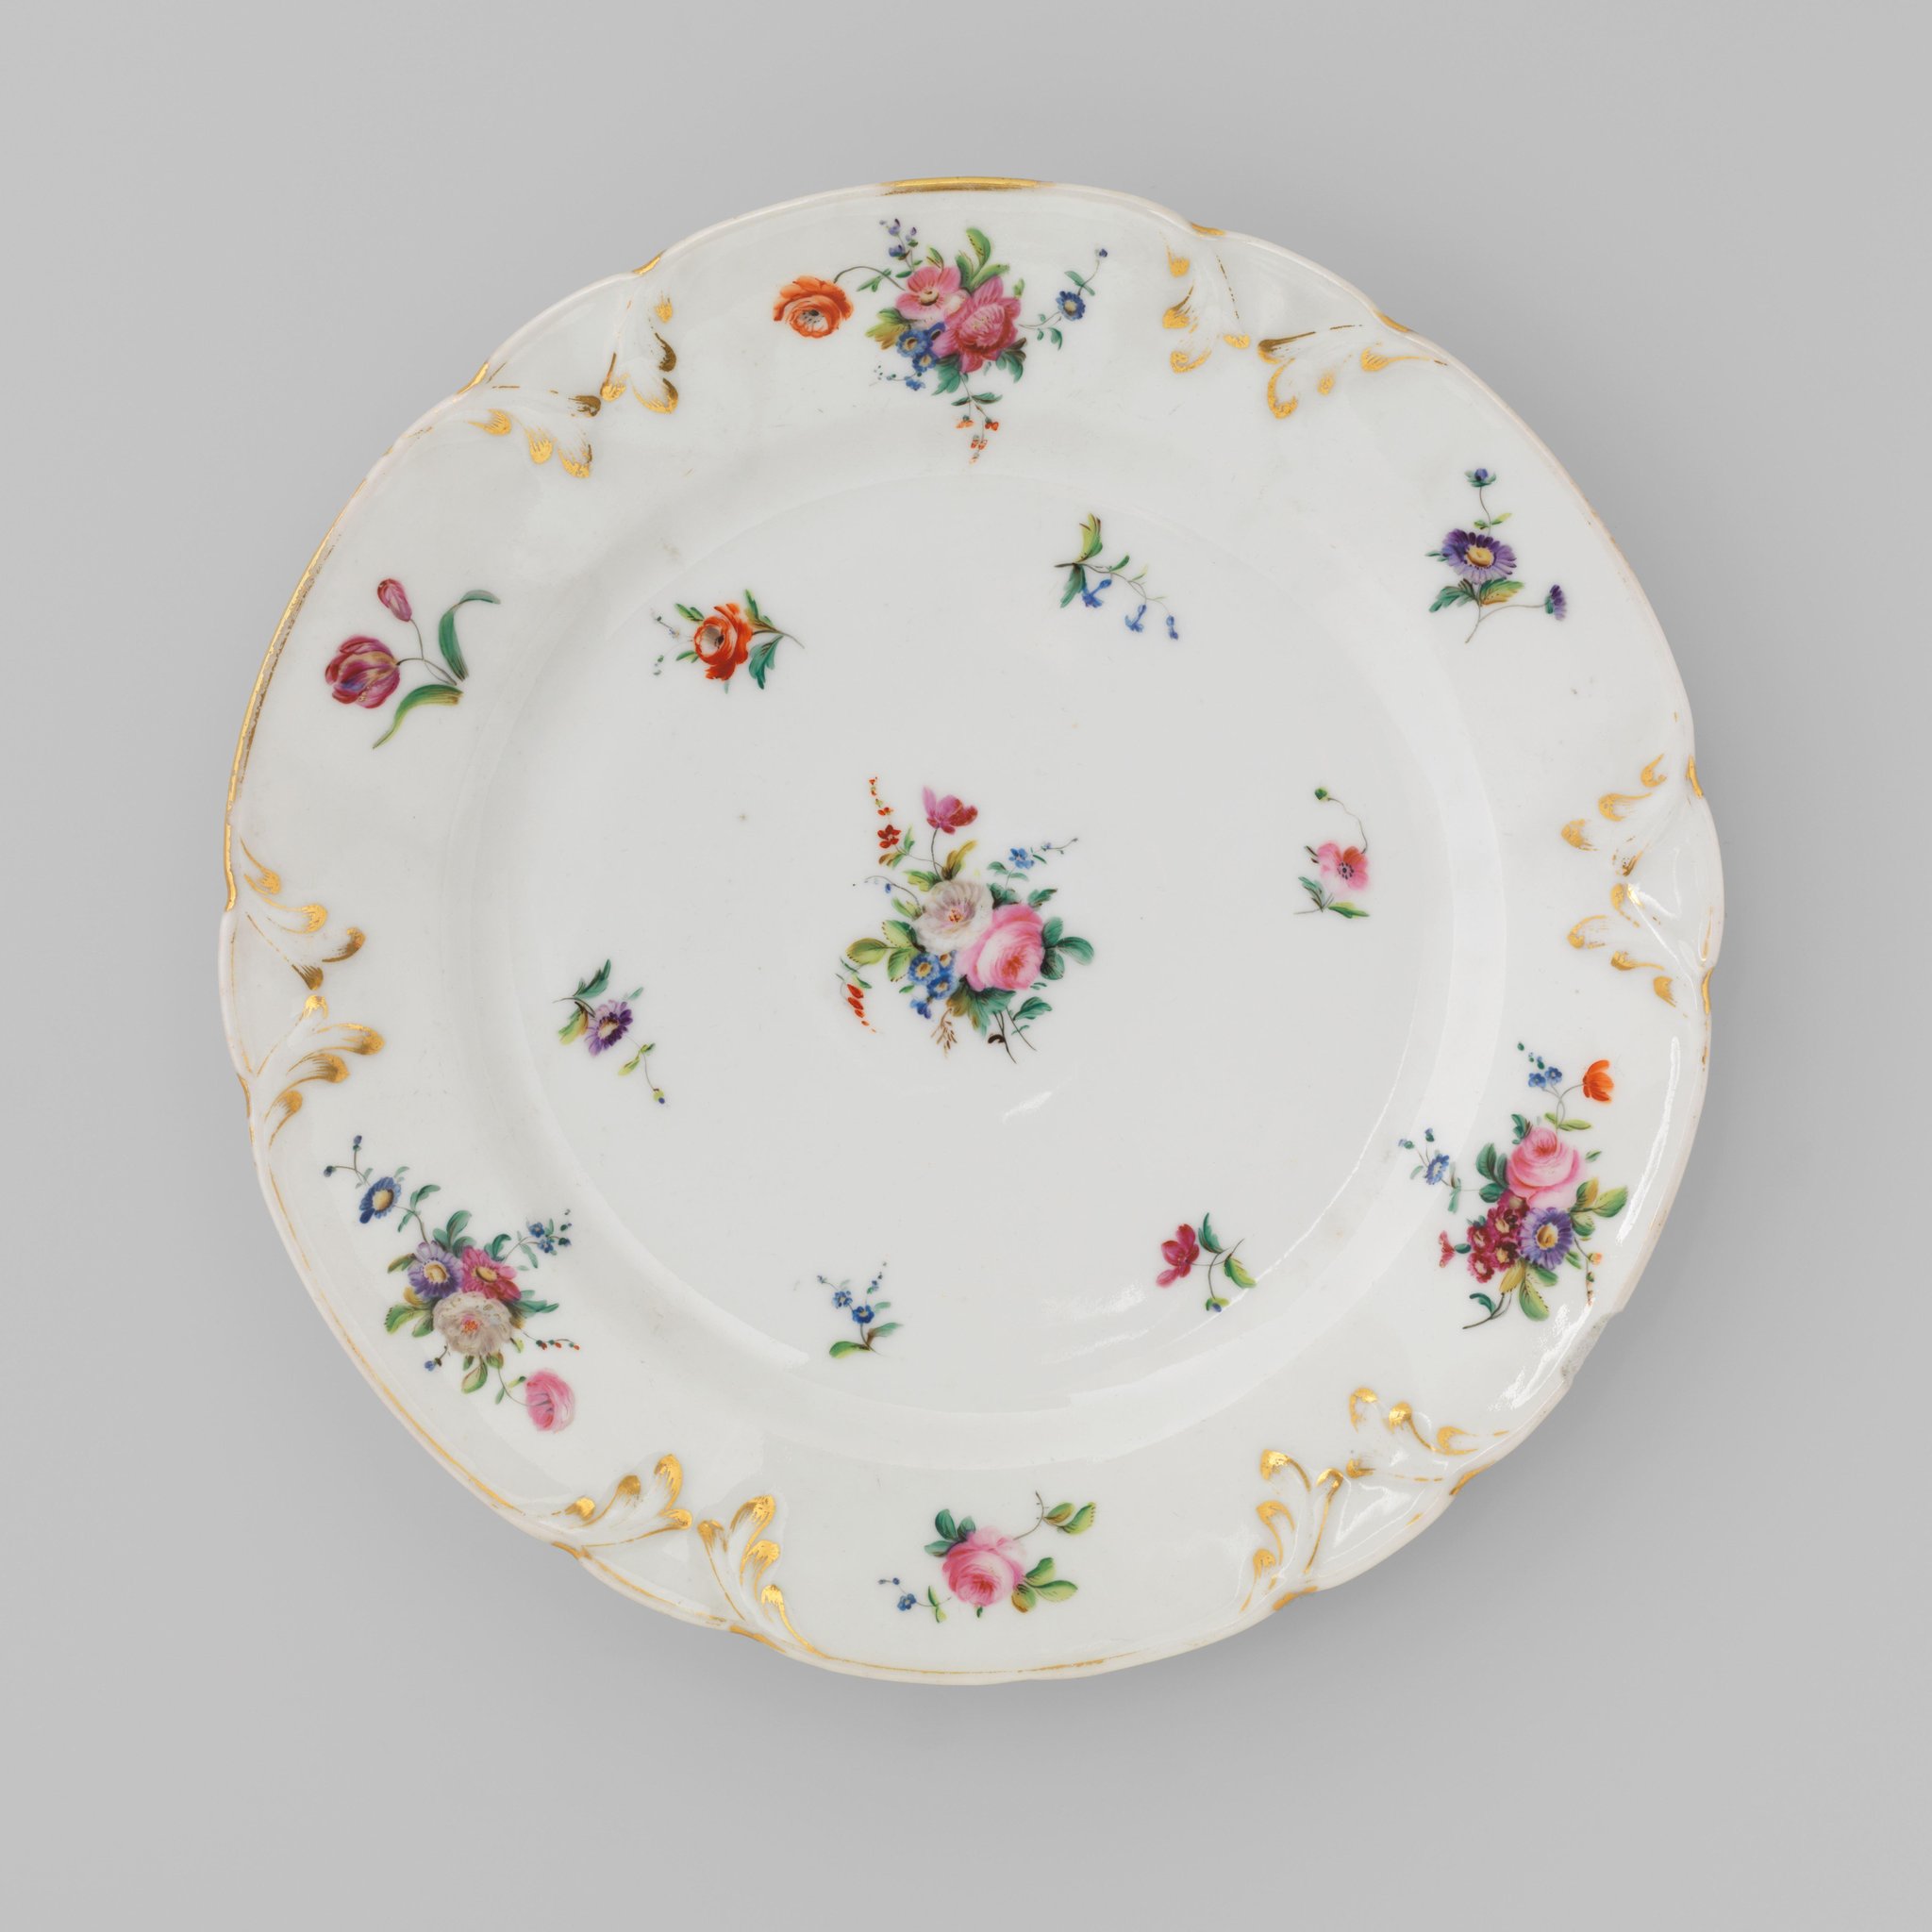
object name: plate dish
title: Plate with bouquets and flower sprays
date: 1839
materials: glaze, gold, paint, porcelain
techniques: firing, forming, gilding, turning, vitrification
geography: paris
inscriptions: mark: ‘DENUELLE/ Boulevard St. Denis 18/ à Paris’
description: Bord van porselein met een gelobde rand, beschilderd op het glazuur in blauw, rood, roze, groen, geel, paars, zwart en goud. Op het plat boeketten van verschillende bloemen en strooibloemen. Vanuit de gelobde, gouden rand, gemodelleerde bladranken in reliëf, aangezet met goud. Hiertussen boeketten. Drie proenen op de onderzijde. Gemerkt op de onderzijde met 'DENUELLE/ Boulevard St. Denis 18/ à Paris'.